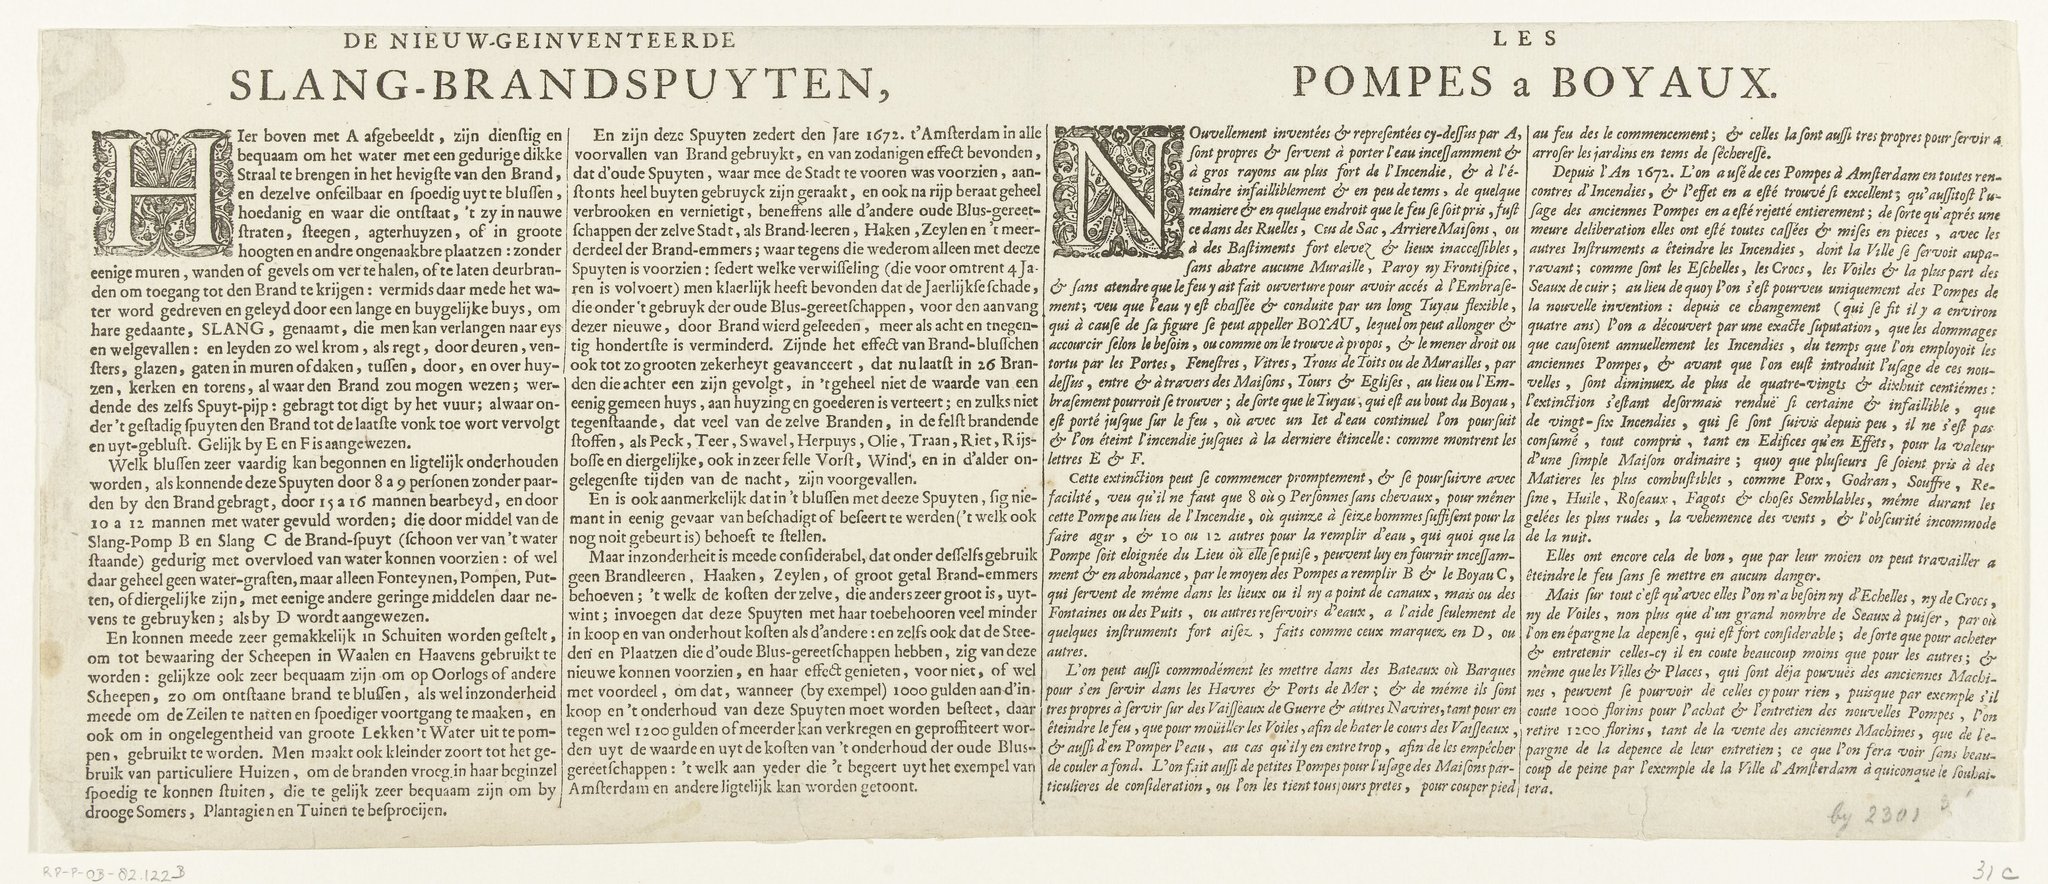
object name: text sheet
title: Tekstblad bij de prent over het gebruik van de nieuwe brandspuitslangen, 1677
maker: joseph mulder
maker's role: print maker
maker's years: 1658-1718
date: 1677-1718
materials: paper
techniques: letterpress printing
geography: northern netherlands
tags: amsterdam, painter, print maker, draughtsman, jan van der heyden, jan van der heyden (de jonge)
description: Tekstblad bij de prent over het gebruik van de nieuwe slangbrandspuiten van Jan van der Heyden en Jan van der Heyden de Jonge bij het blussen van een brand in een kerk of paleis een imaginaire stad. Tekst in 4 kolommen in het Nederlands en Frans.